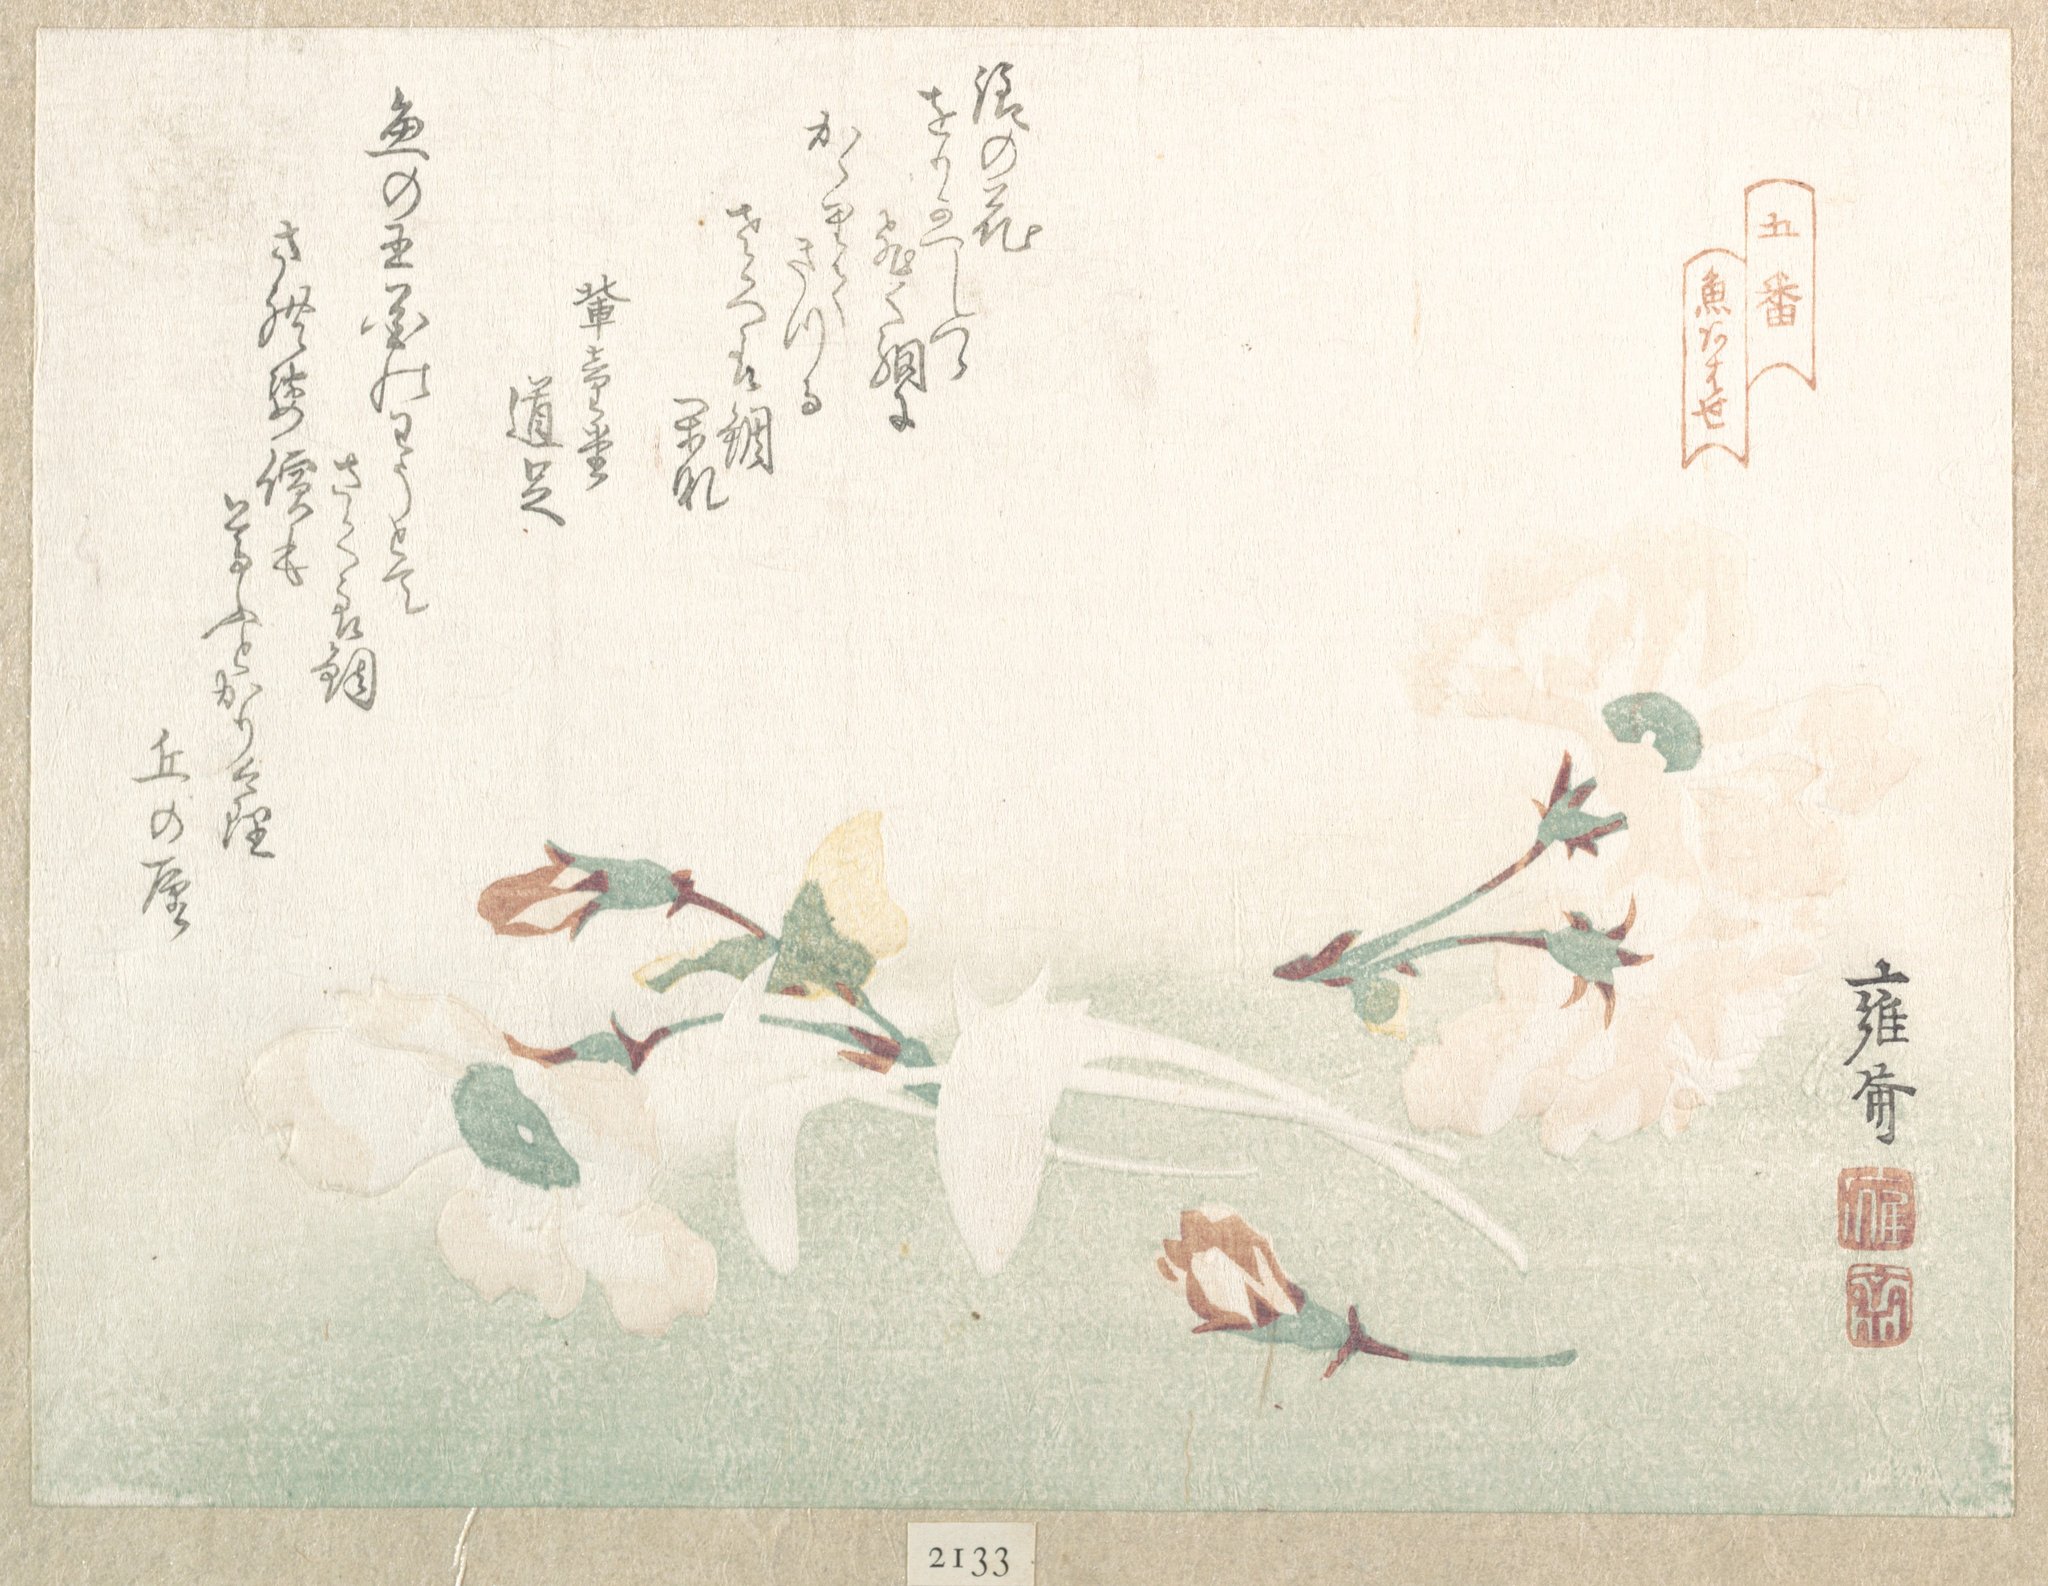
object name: print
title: Cherry Flowers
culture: japanese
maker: kikuchi yōsai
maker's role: artist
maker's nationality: japanese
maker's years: 1788-1878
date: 1801-1900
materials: ink, paper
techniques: surimono, woodblock print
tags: flowers